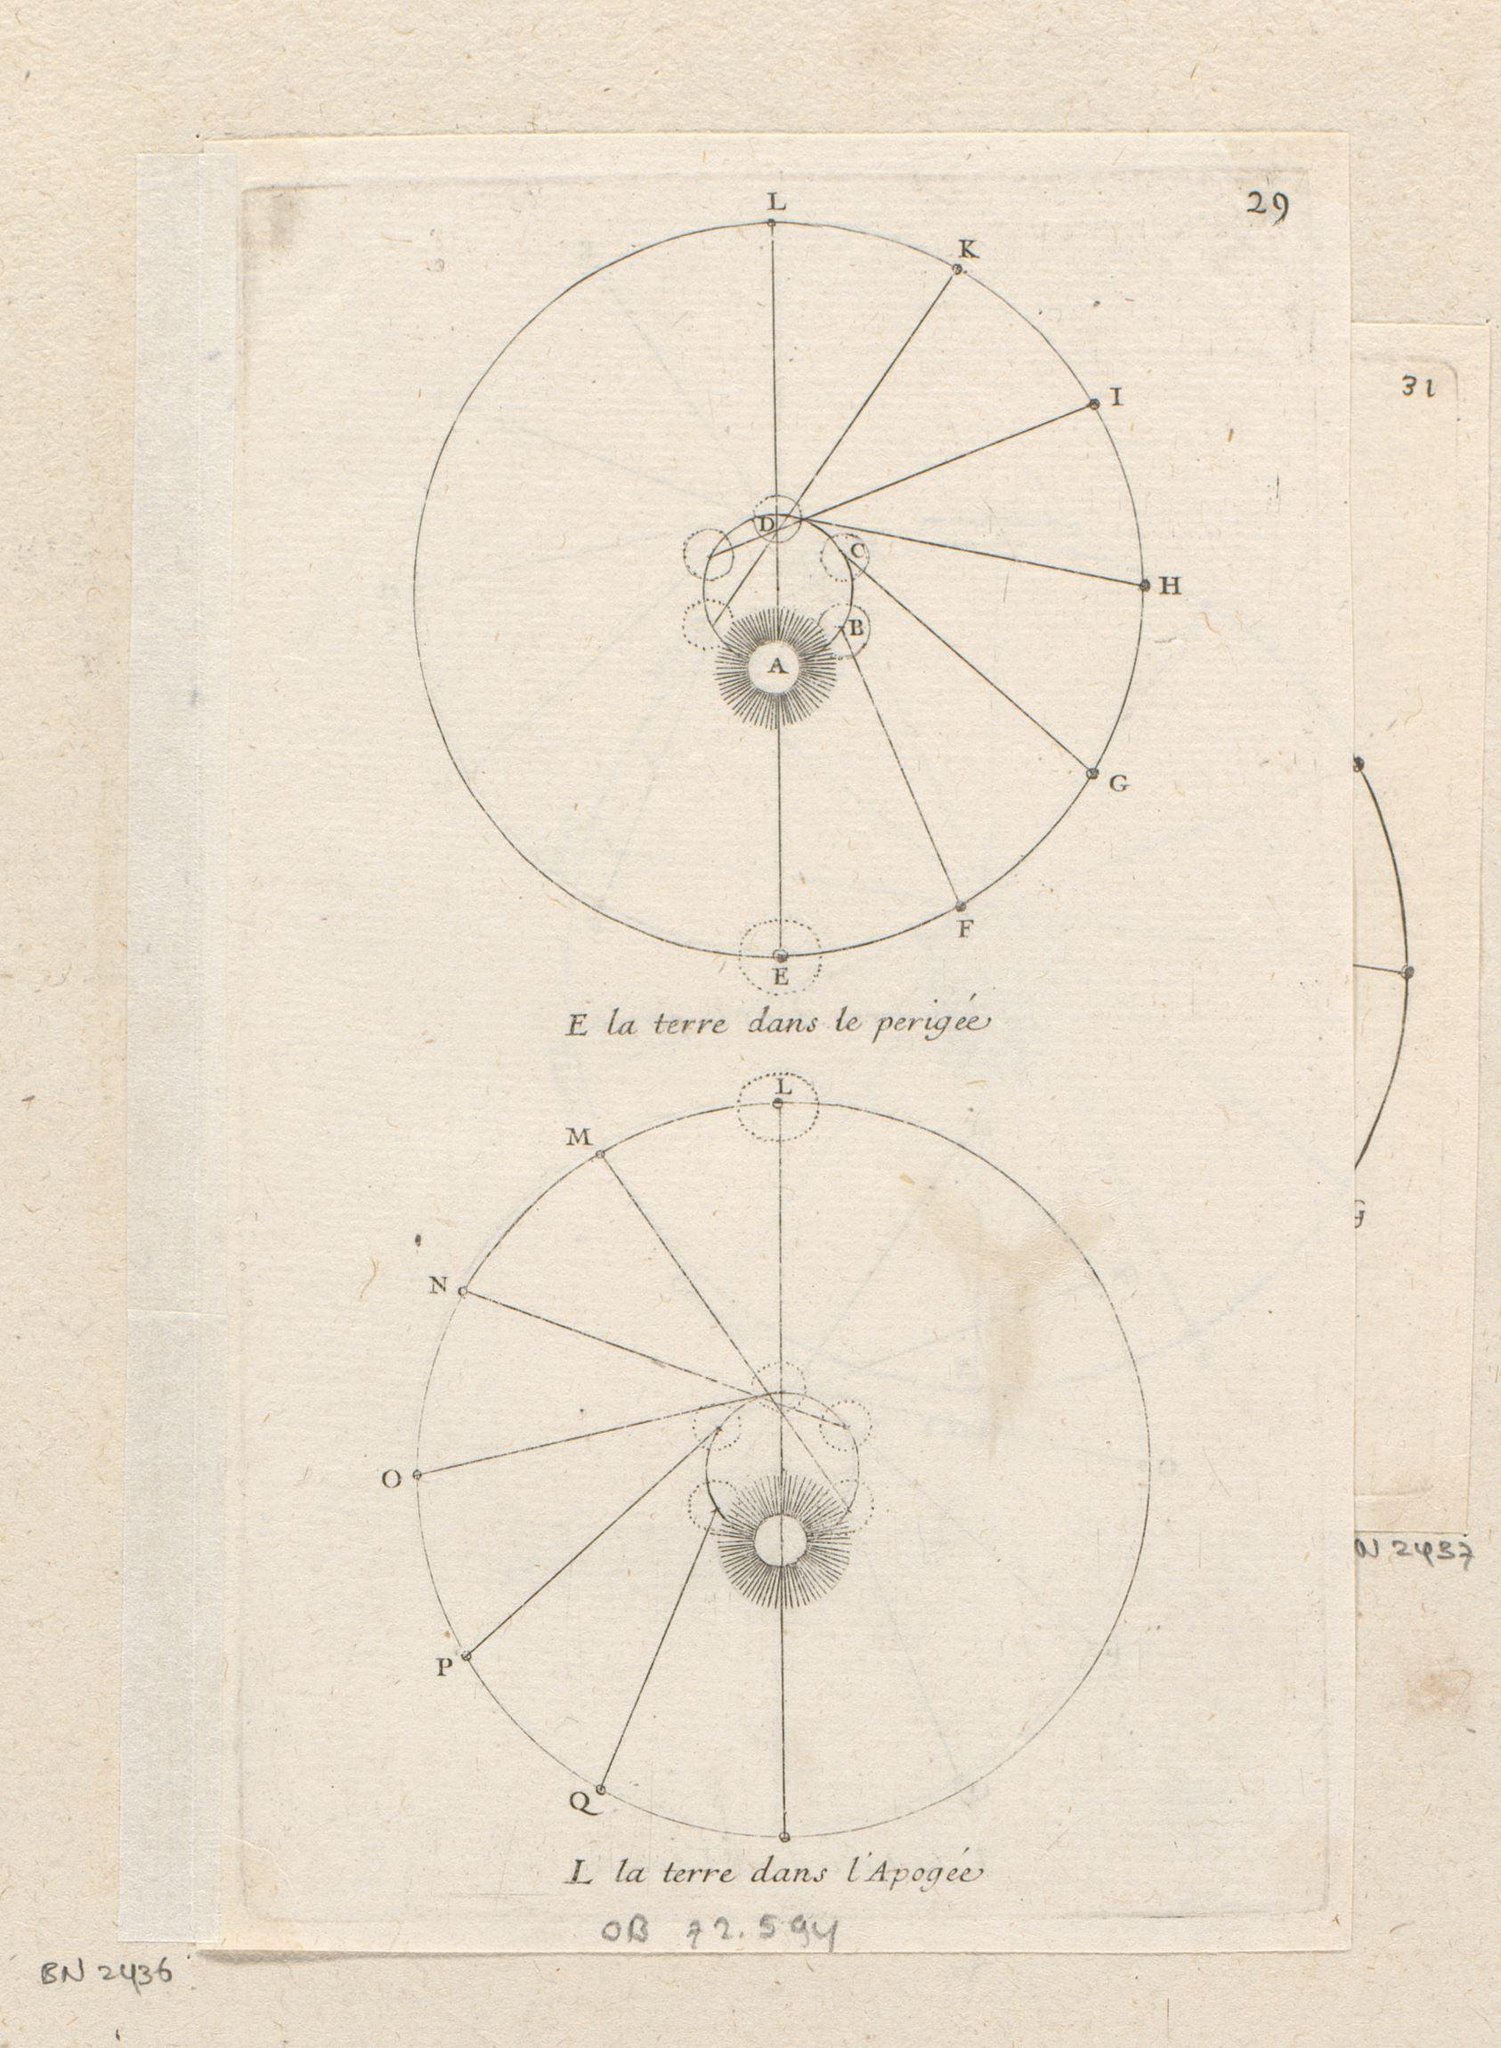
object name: book illustration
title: Positie van de Aarde op het moment van het perigeum en die van de zenit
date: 1706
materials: paper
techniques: etching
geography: paris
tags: earth, world as celestial body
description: Prent uit: Leclerc, Sébastien. Nouveau systeme du monde conforme à l'Ecriture sainte. Où les phénomènes sont expliquez sans excentricité de mouvement (...). Paris: Pierre Giffart, 1706.